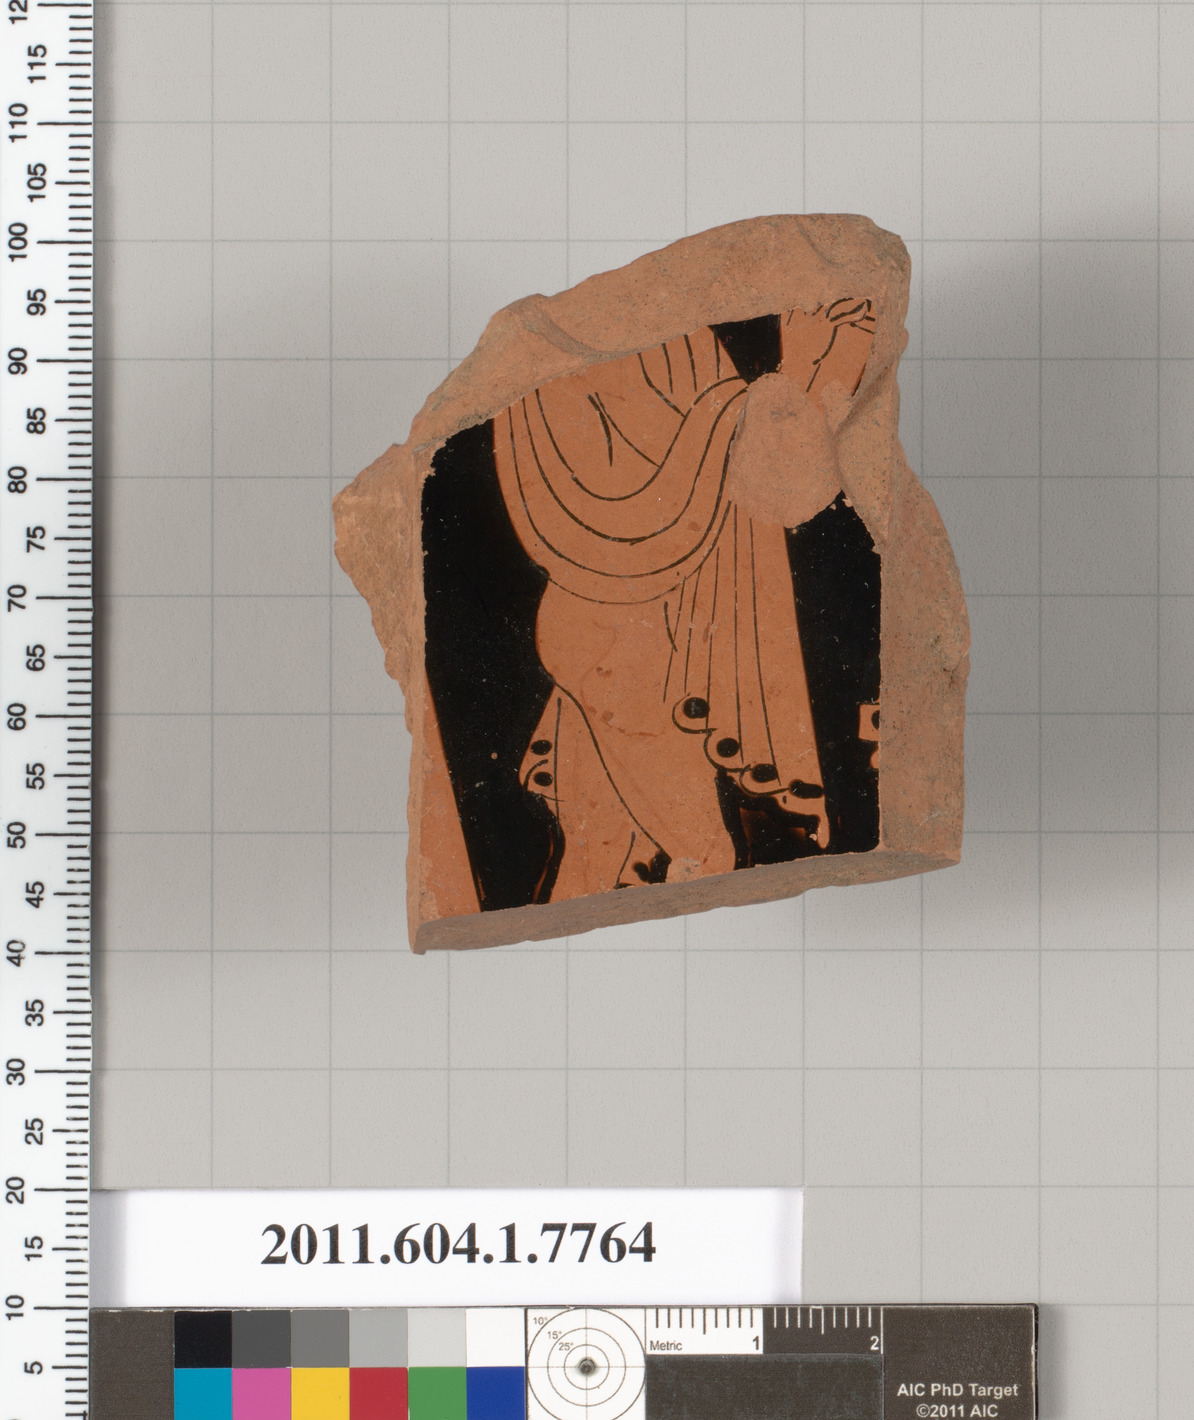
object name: kylix fragment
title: Terracotta fragment of a kylix (drinking cup)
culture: greek, attic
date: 460-450 BCE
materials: terracotta